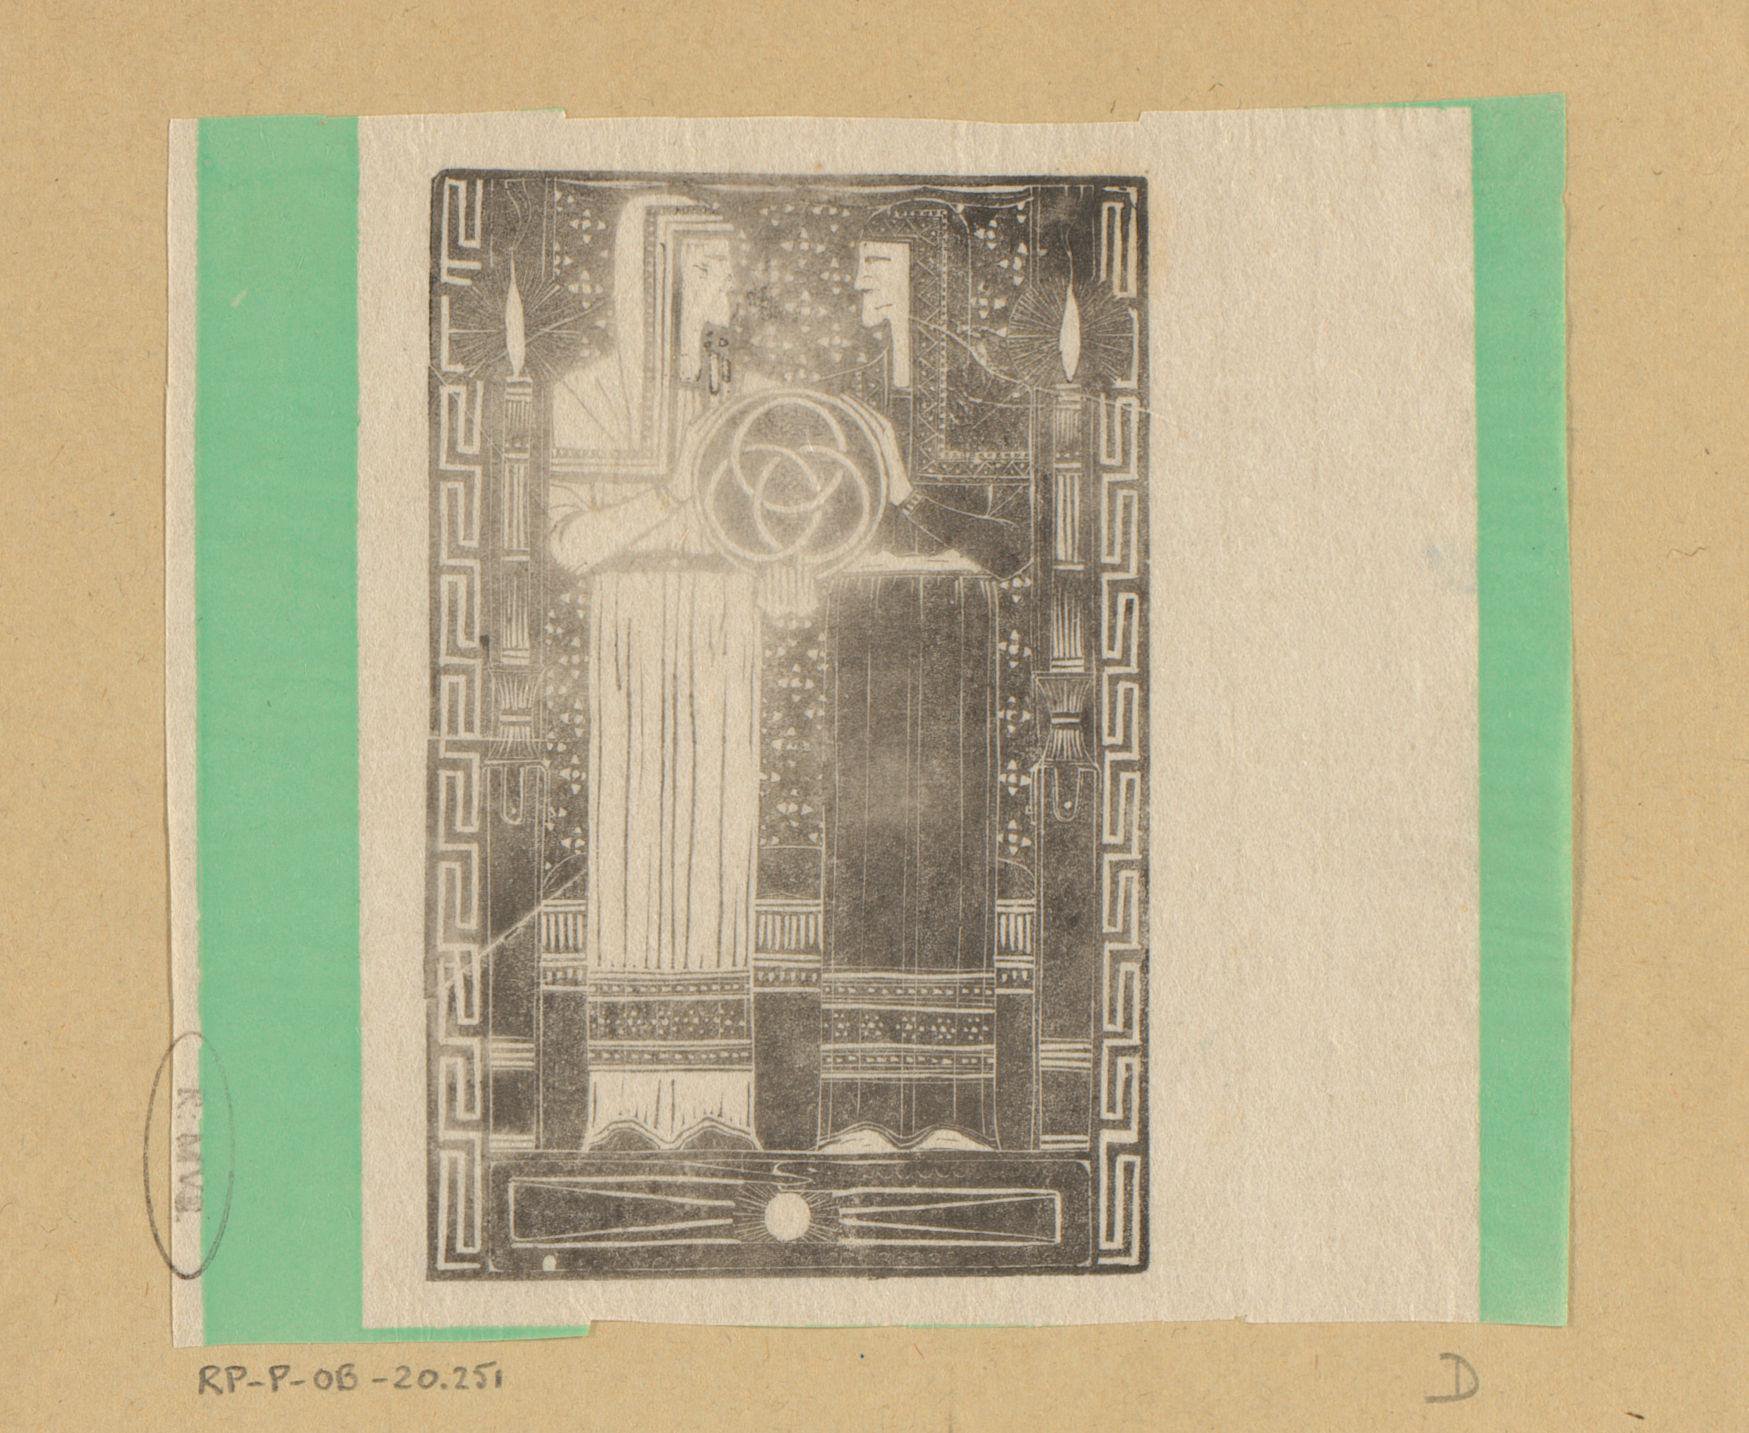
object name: illustration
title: De geest des tijds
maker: mathieu lauweriks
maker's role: designer, draughtsman, print maker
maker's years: 1864-1932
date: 1895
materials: paper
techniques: woodcut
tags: three interlocked circles ~ trinity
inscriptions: collector's mark: Lugt 2228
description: Twee figuren in lange gewaden; de linker in het wit en de rechter in het zwart. Samen houden zij een cirkel vast met daarin drie Borromeaanse ringen. Onder hun voeten de zon. Deze prent maakt deel uit van een album.